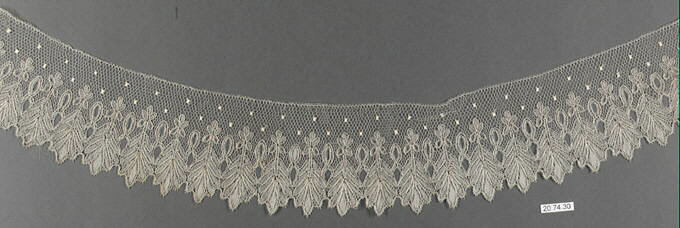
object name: fragment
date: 1801-1900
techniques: lace